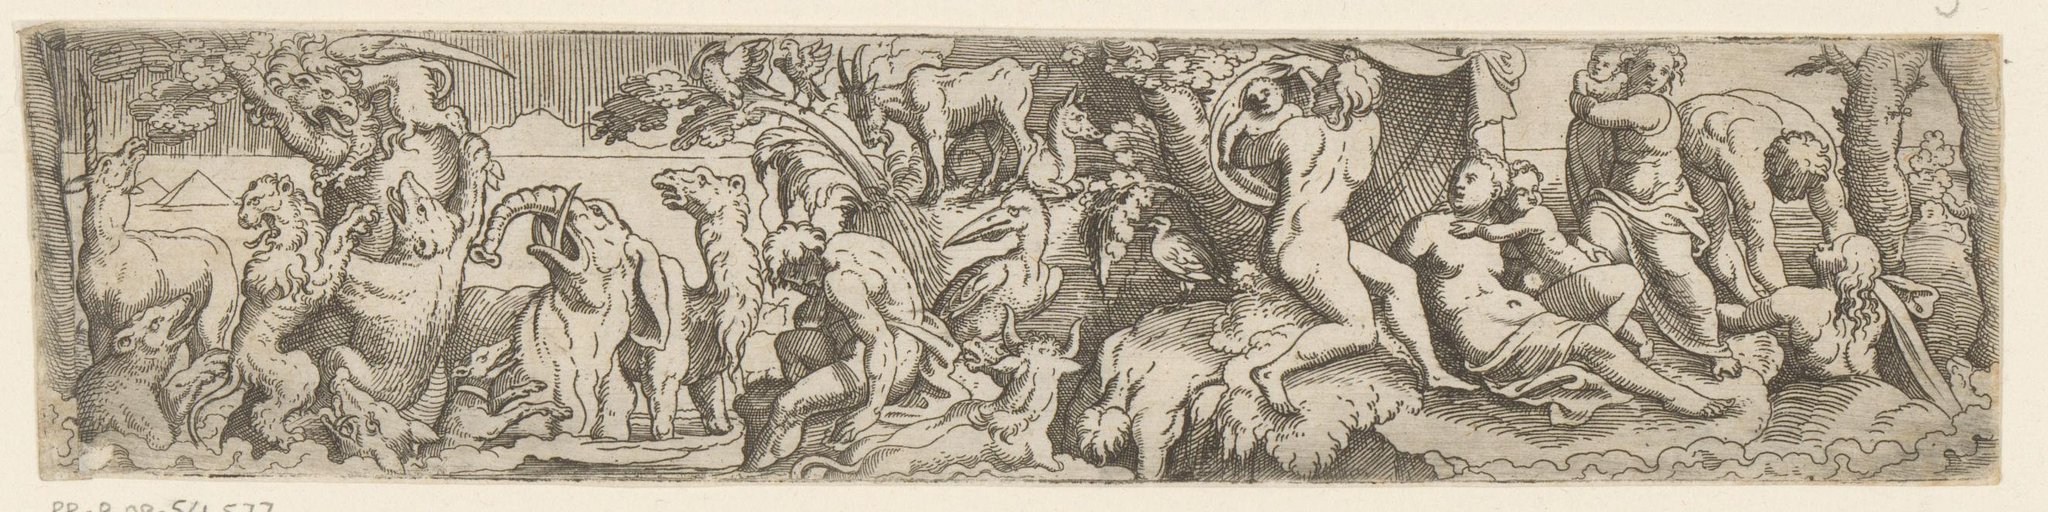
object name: print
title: Zondvloed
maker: virgilius solis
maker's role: draughtsman, print maker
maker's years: 1514-1562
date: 1524-1562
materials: paper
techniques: engraving, etching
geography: nuremberg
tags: the flood and destruction of mankind ~ story of noah (genesis 7:10 - 8:17)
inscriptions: number: ‘2’, collector's mark: Lugt 2228